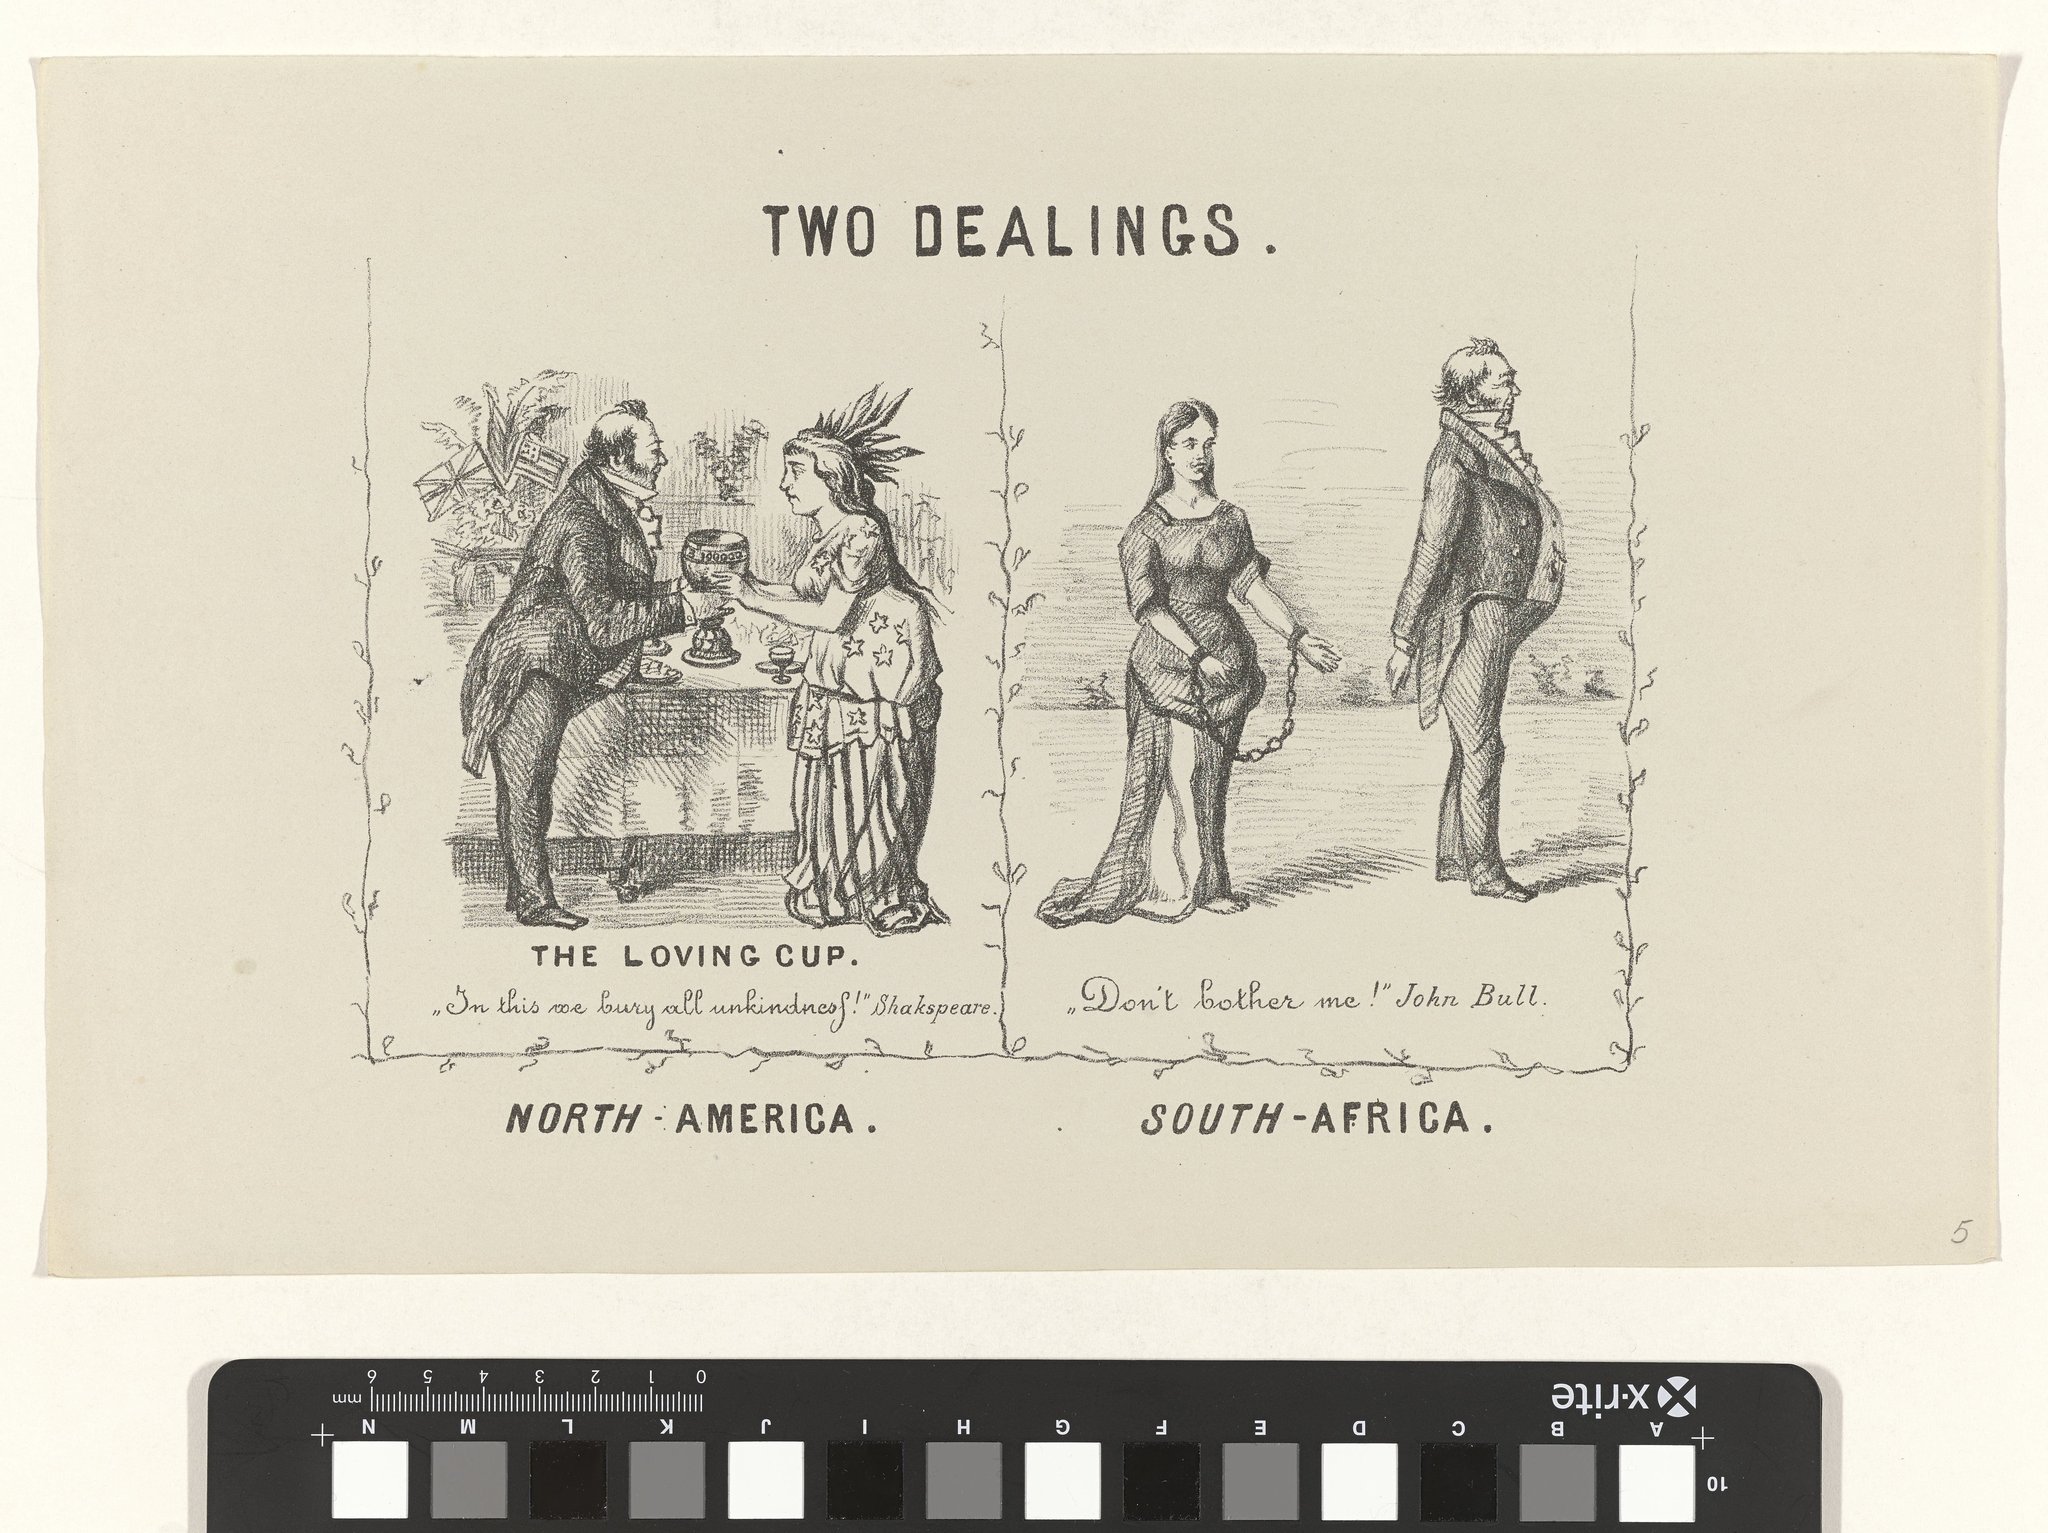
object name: cartoon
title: Hoe verschillend Groot-Brittannië Amerika en Zuid-Afrika behandelt, 1877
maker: Anonymous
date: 1877-1880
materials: paper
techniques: lithograph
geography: south africa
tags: personifications of countries, nations, states, districts, etc., indigenous peoples of north america, prisoner with hands bound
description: Links overhandigt John Bull een rijke schadevergoeding aan de Verenigde Staten; rechts negeert John Bull de geketende Transvaal. Onderdeel van de serie van elf spotprenten op de Britse annexatie van Transvaal in 1877.